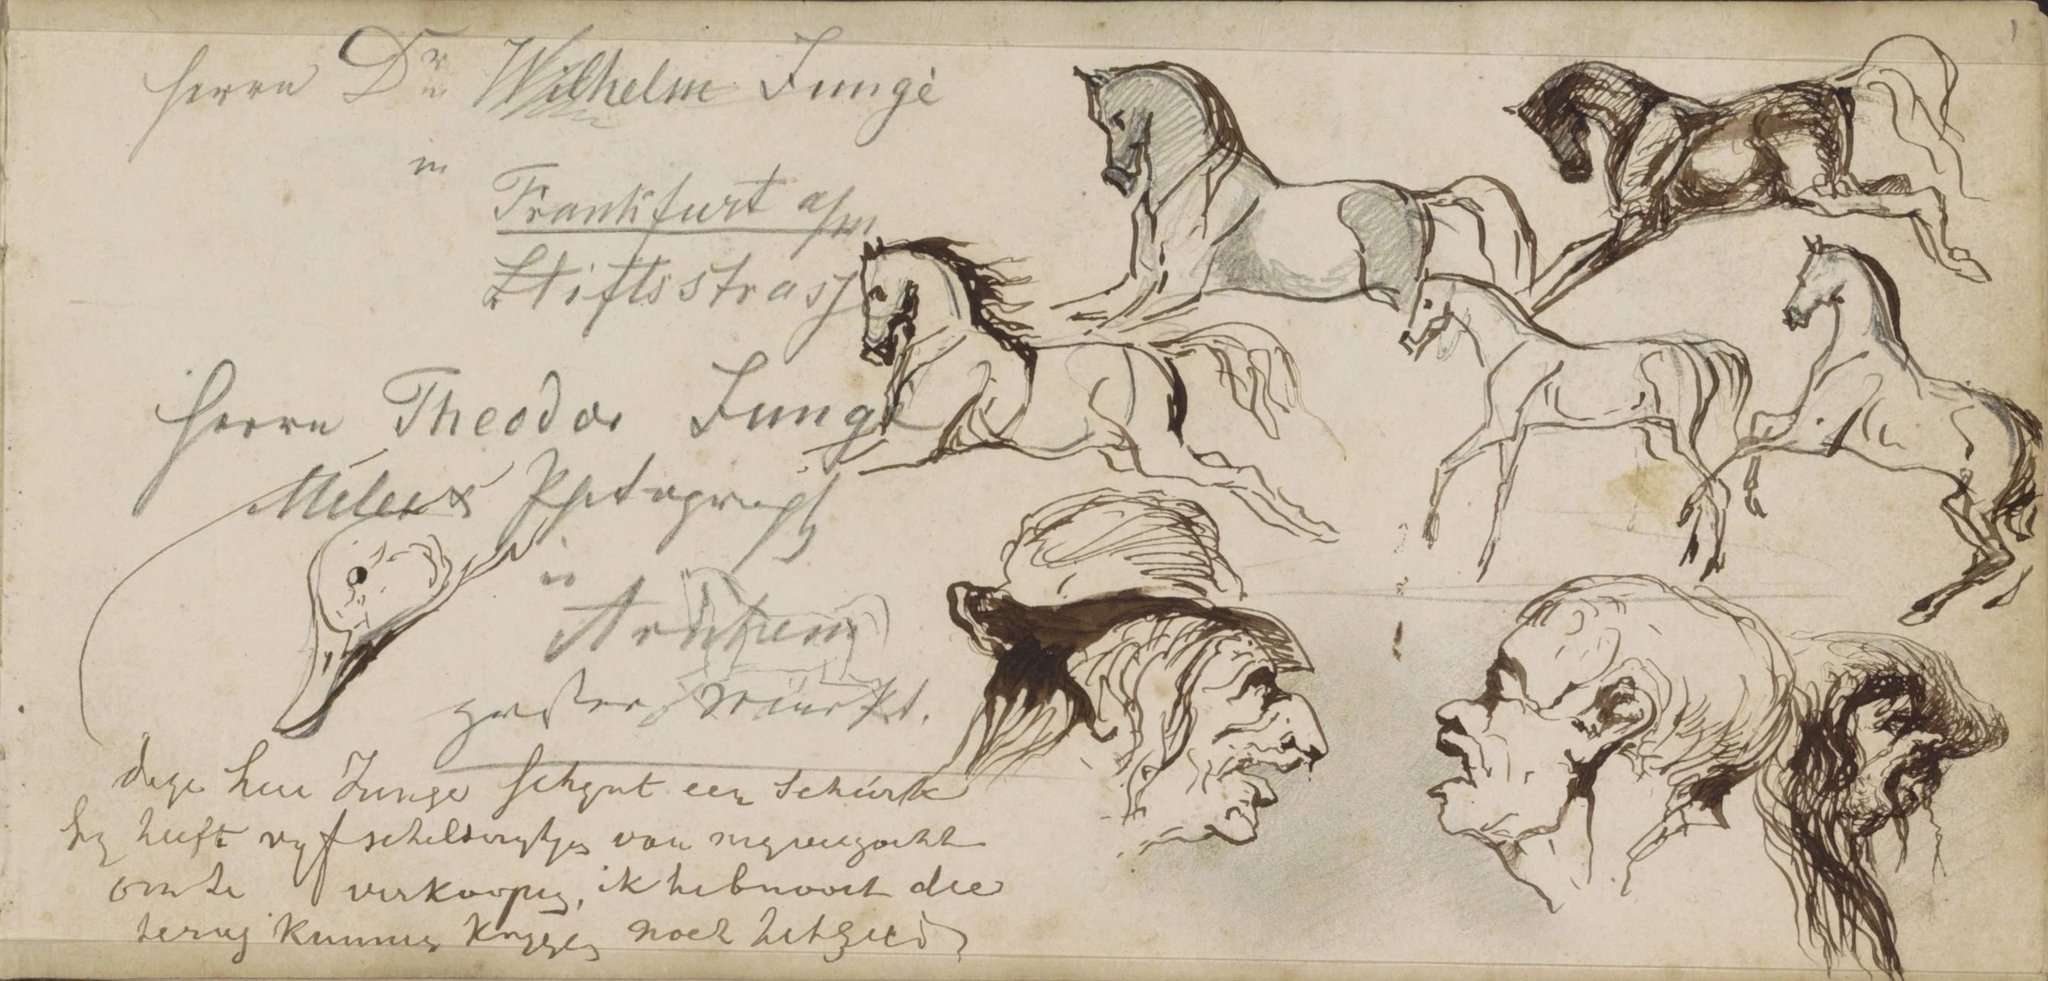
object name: sketchbook leaf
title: Paarden, mannenkoppen en een eendenkop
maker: johannes tavenraat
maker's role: draughtsman, painter, print maker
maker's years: 1809-1881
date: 1840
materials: ink, paper, pencil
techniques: pen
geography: cleves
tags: head (human), adult man, head-gear: hat (+ men's clothes), horse, water-birds: duck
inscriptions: annotation: ‘[...] D Wilhelm Junge/ Frankfurt a/m/ [...]tiftstrasse/ [...] Theod[...] Junge/ [...]/ deze heer Junge sch[...] een schurk/ hij heeft vijf scheld[...] van [...]/ om te verkoopen, ik heb nooit die/ terug kunnen krijgen [...]oe[...] het geld’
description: Blad 1 recto uit een schetsboek met 63 bladen.